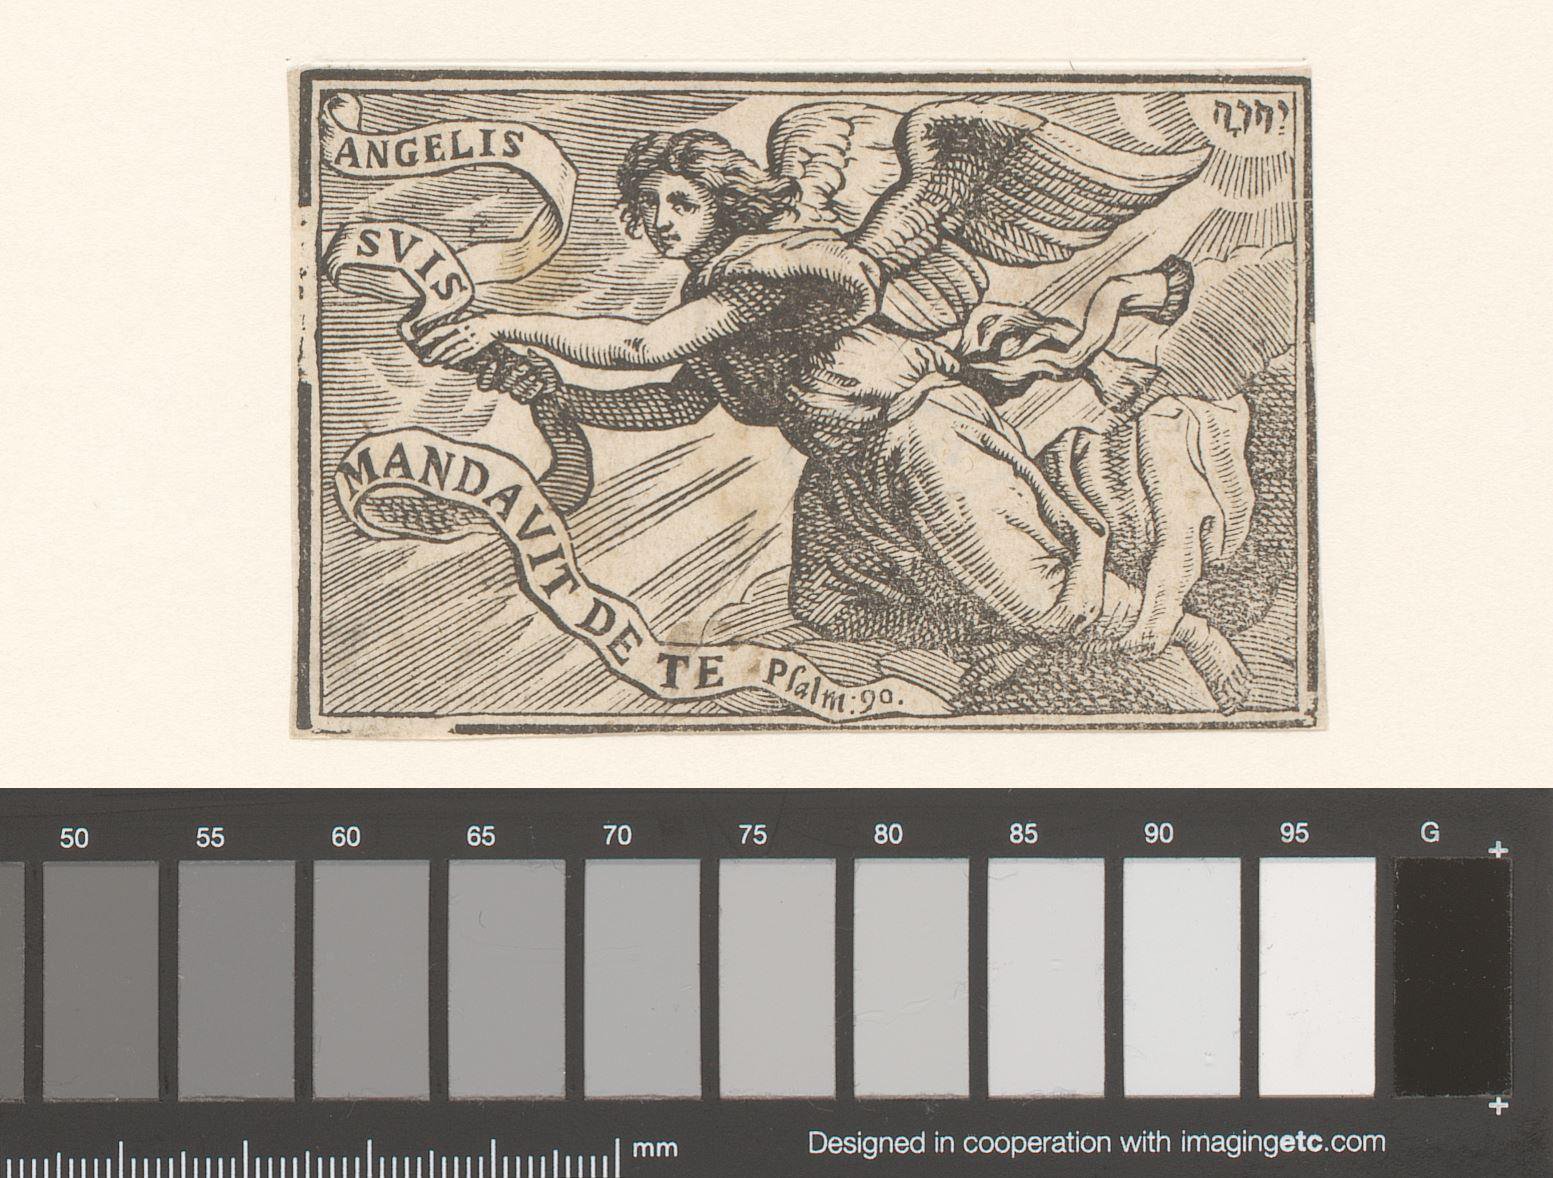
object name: print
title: Engel met banderol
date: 1600-1699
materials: paper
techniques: woodcut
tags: the book of psalms (with book chapter:verse), angels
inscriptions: collector's mark: Lugt 2228